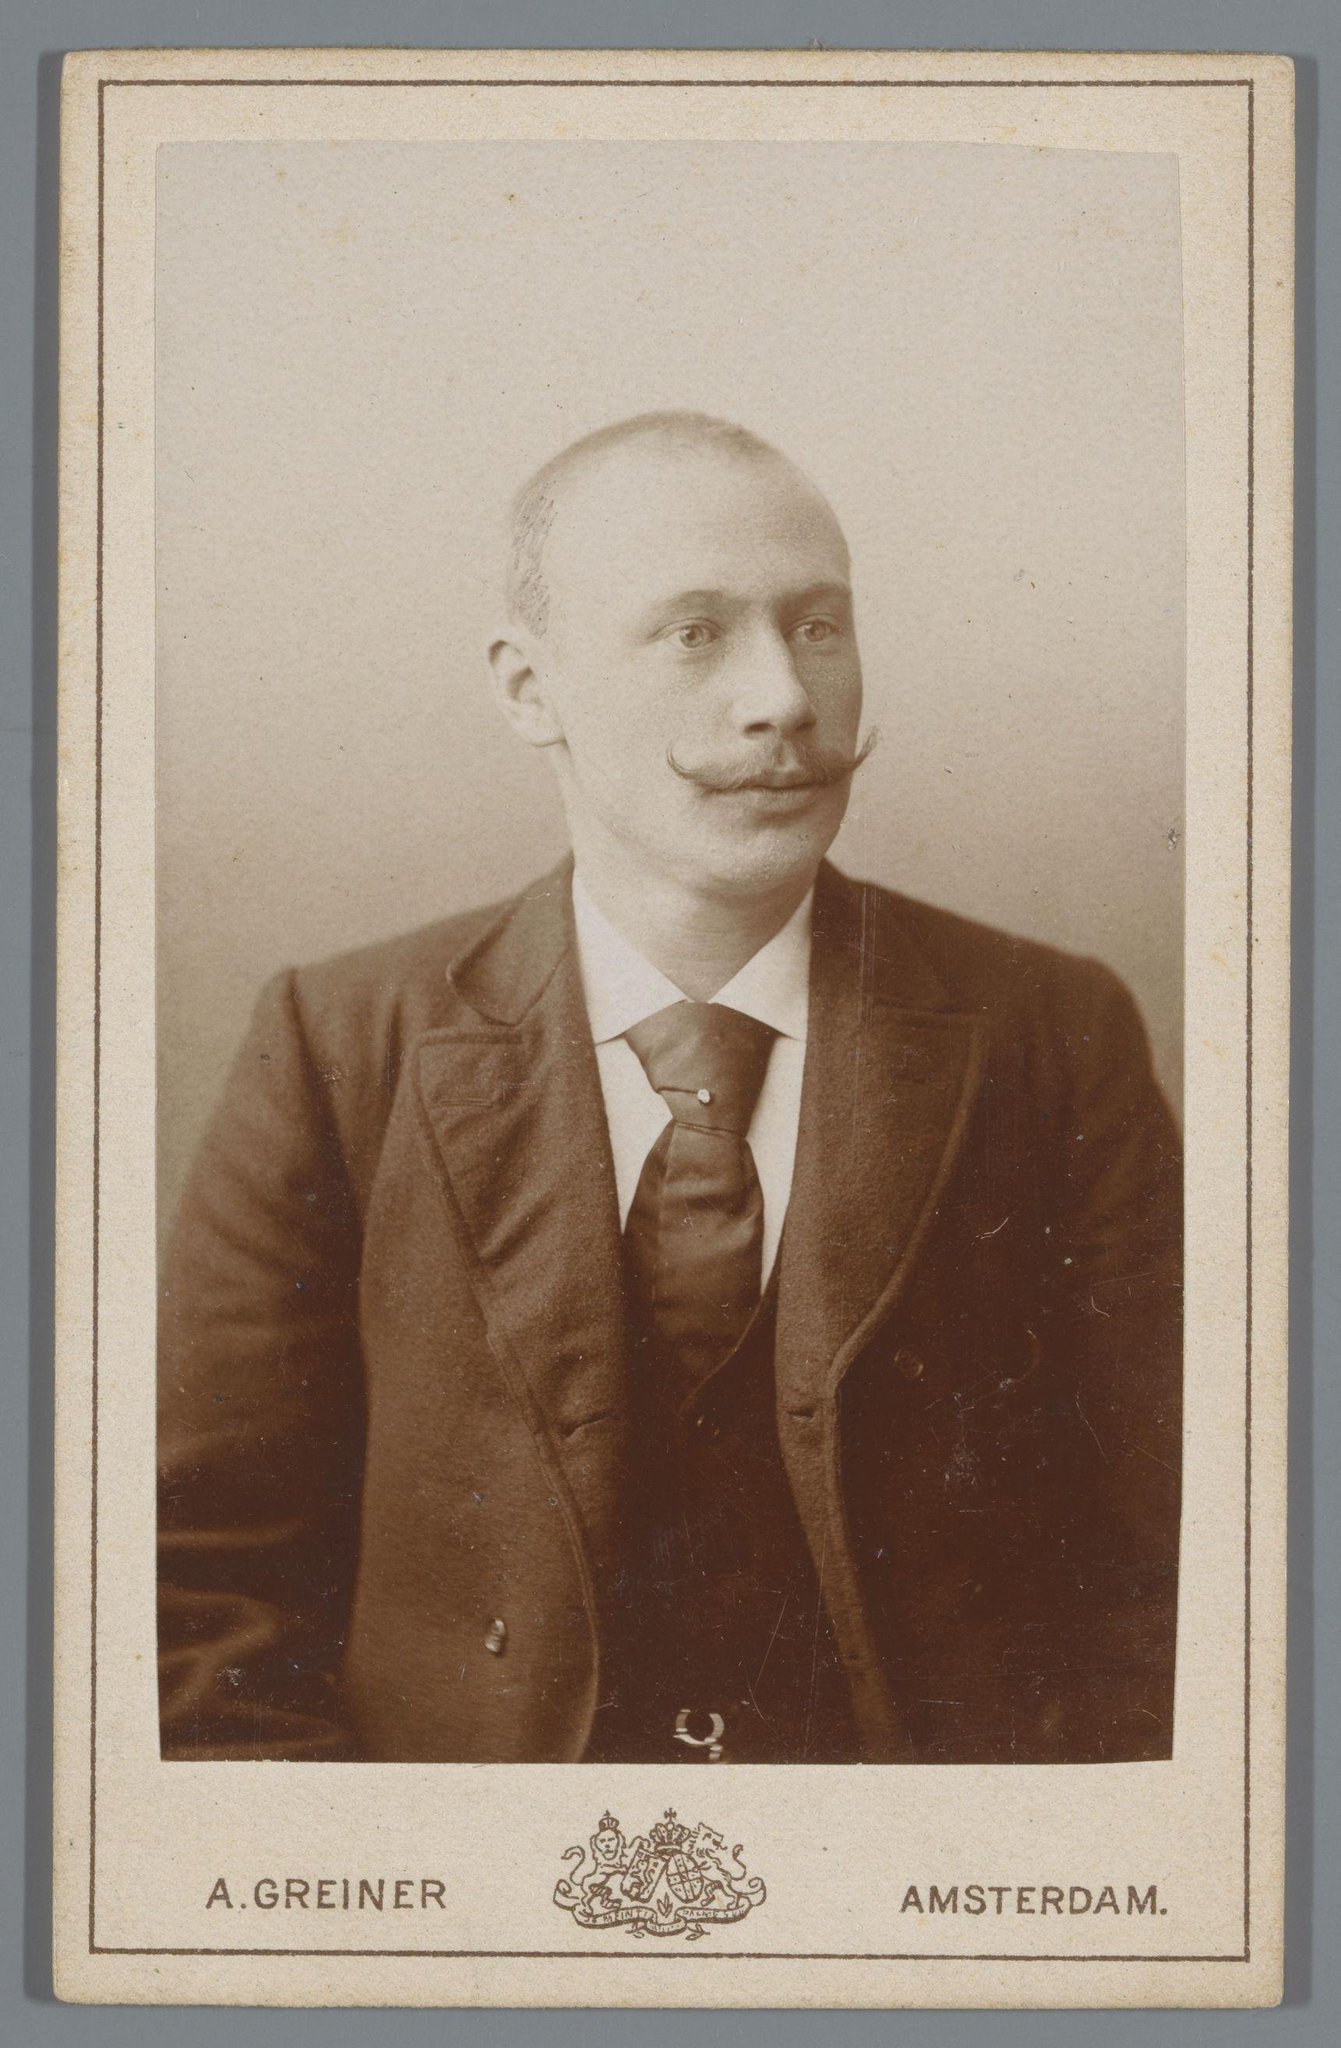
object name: carte de visite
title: Portret van een onbekende man met snor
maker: albert greiner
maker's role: fotograaf, fotostudio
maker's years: 1833-1890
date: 1874-1887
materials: cardboard, photographic support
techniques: daylight paper print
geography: amsterdam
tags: adult man, historical persons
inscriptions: inscription: ‘Photograaf van wijlen Z.M. den Koning Willem III en H.M. de Koningin Weduwe/ ALBERT GREINER/ Amsterdam/ Nieuwendijk 89./ Specialiteit in Vergrootingen.’